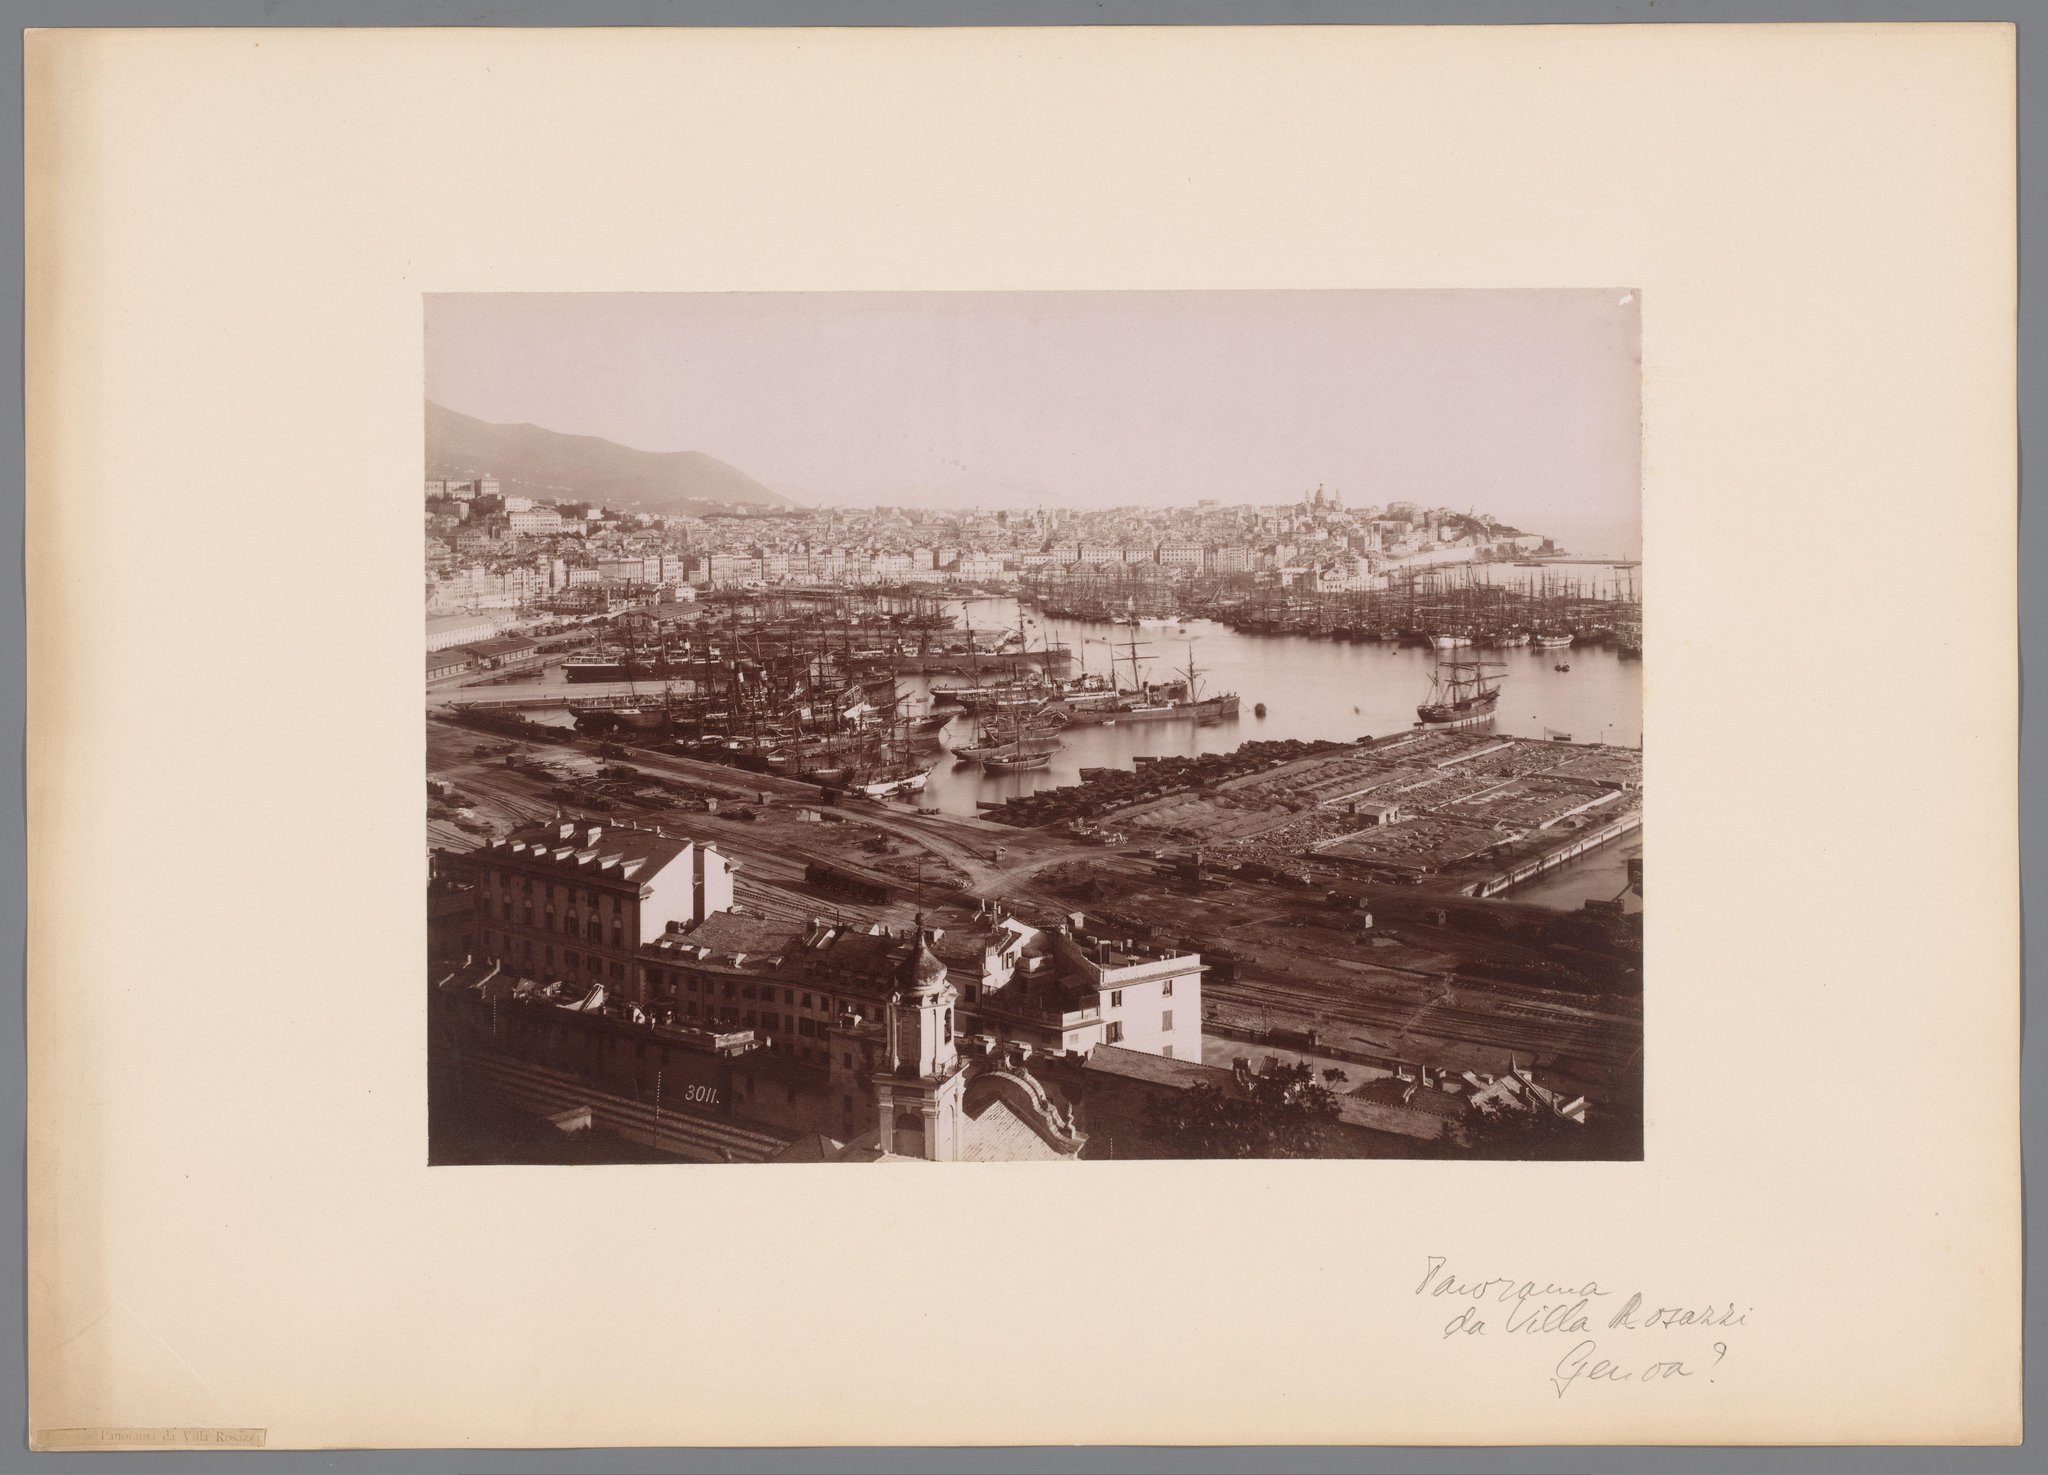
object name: photograph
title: Panorama da Villa Rosazza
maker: alfredo noack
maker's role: fotograaf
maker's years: 1833-1895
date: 1858-1893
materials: cardboard, paper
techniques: albumen print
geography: genoa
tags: harbour, ships (in general)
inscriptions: number: ‘3011’, inscription: ‘Panorama/ da Villa Rozazzi/ Genua?’, number: ‘26.’, inscription: ‘Noack (t)’